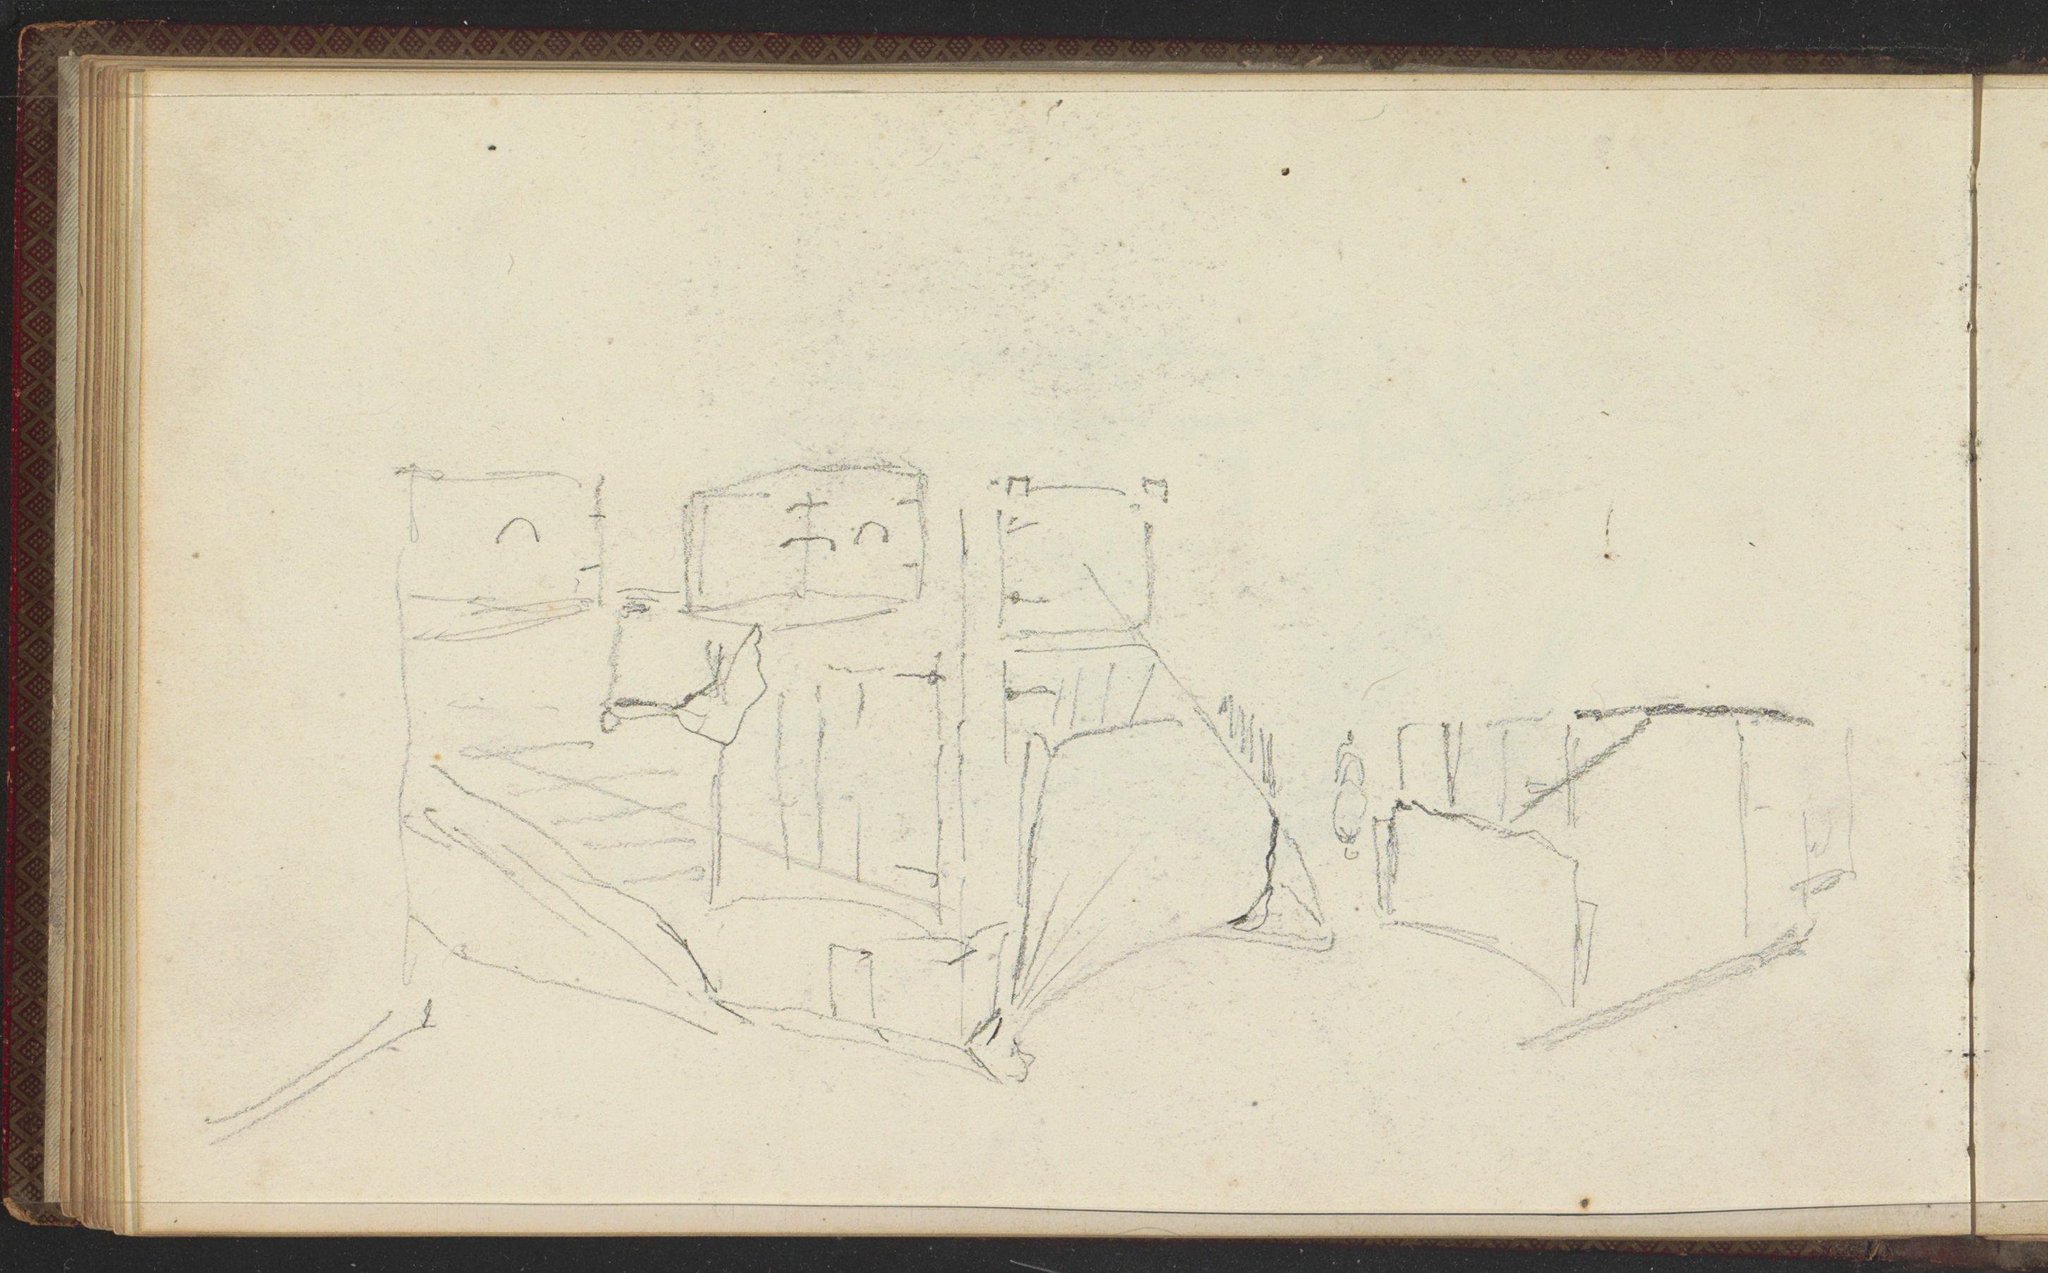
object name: sketchbook leaf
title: Tenten of marktkramen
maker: adrianus eversen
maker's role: draughtsman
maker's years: 1818-1897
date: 1828-1897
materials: paper, pencil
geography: netherlands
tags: tent, stall, booth (~ market)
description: Links een figuur voor een kraam, gezien vanaf de zijkant. Rechts een tent of kraam met kisten. Blad 37 verso uit een schetsboek met 52 bladen vervaardigd in de omgeving van Kampen, Hattem, Hoorn en Zwolle.